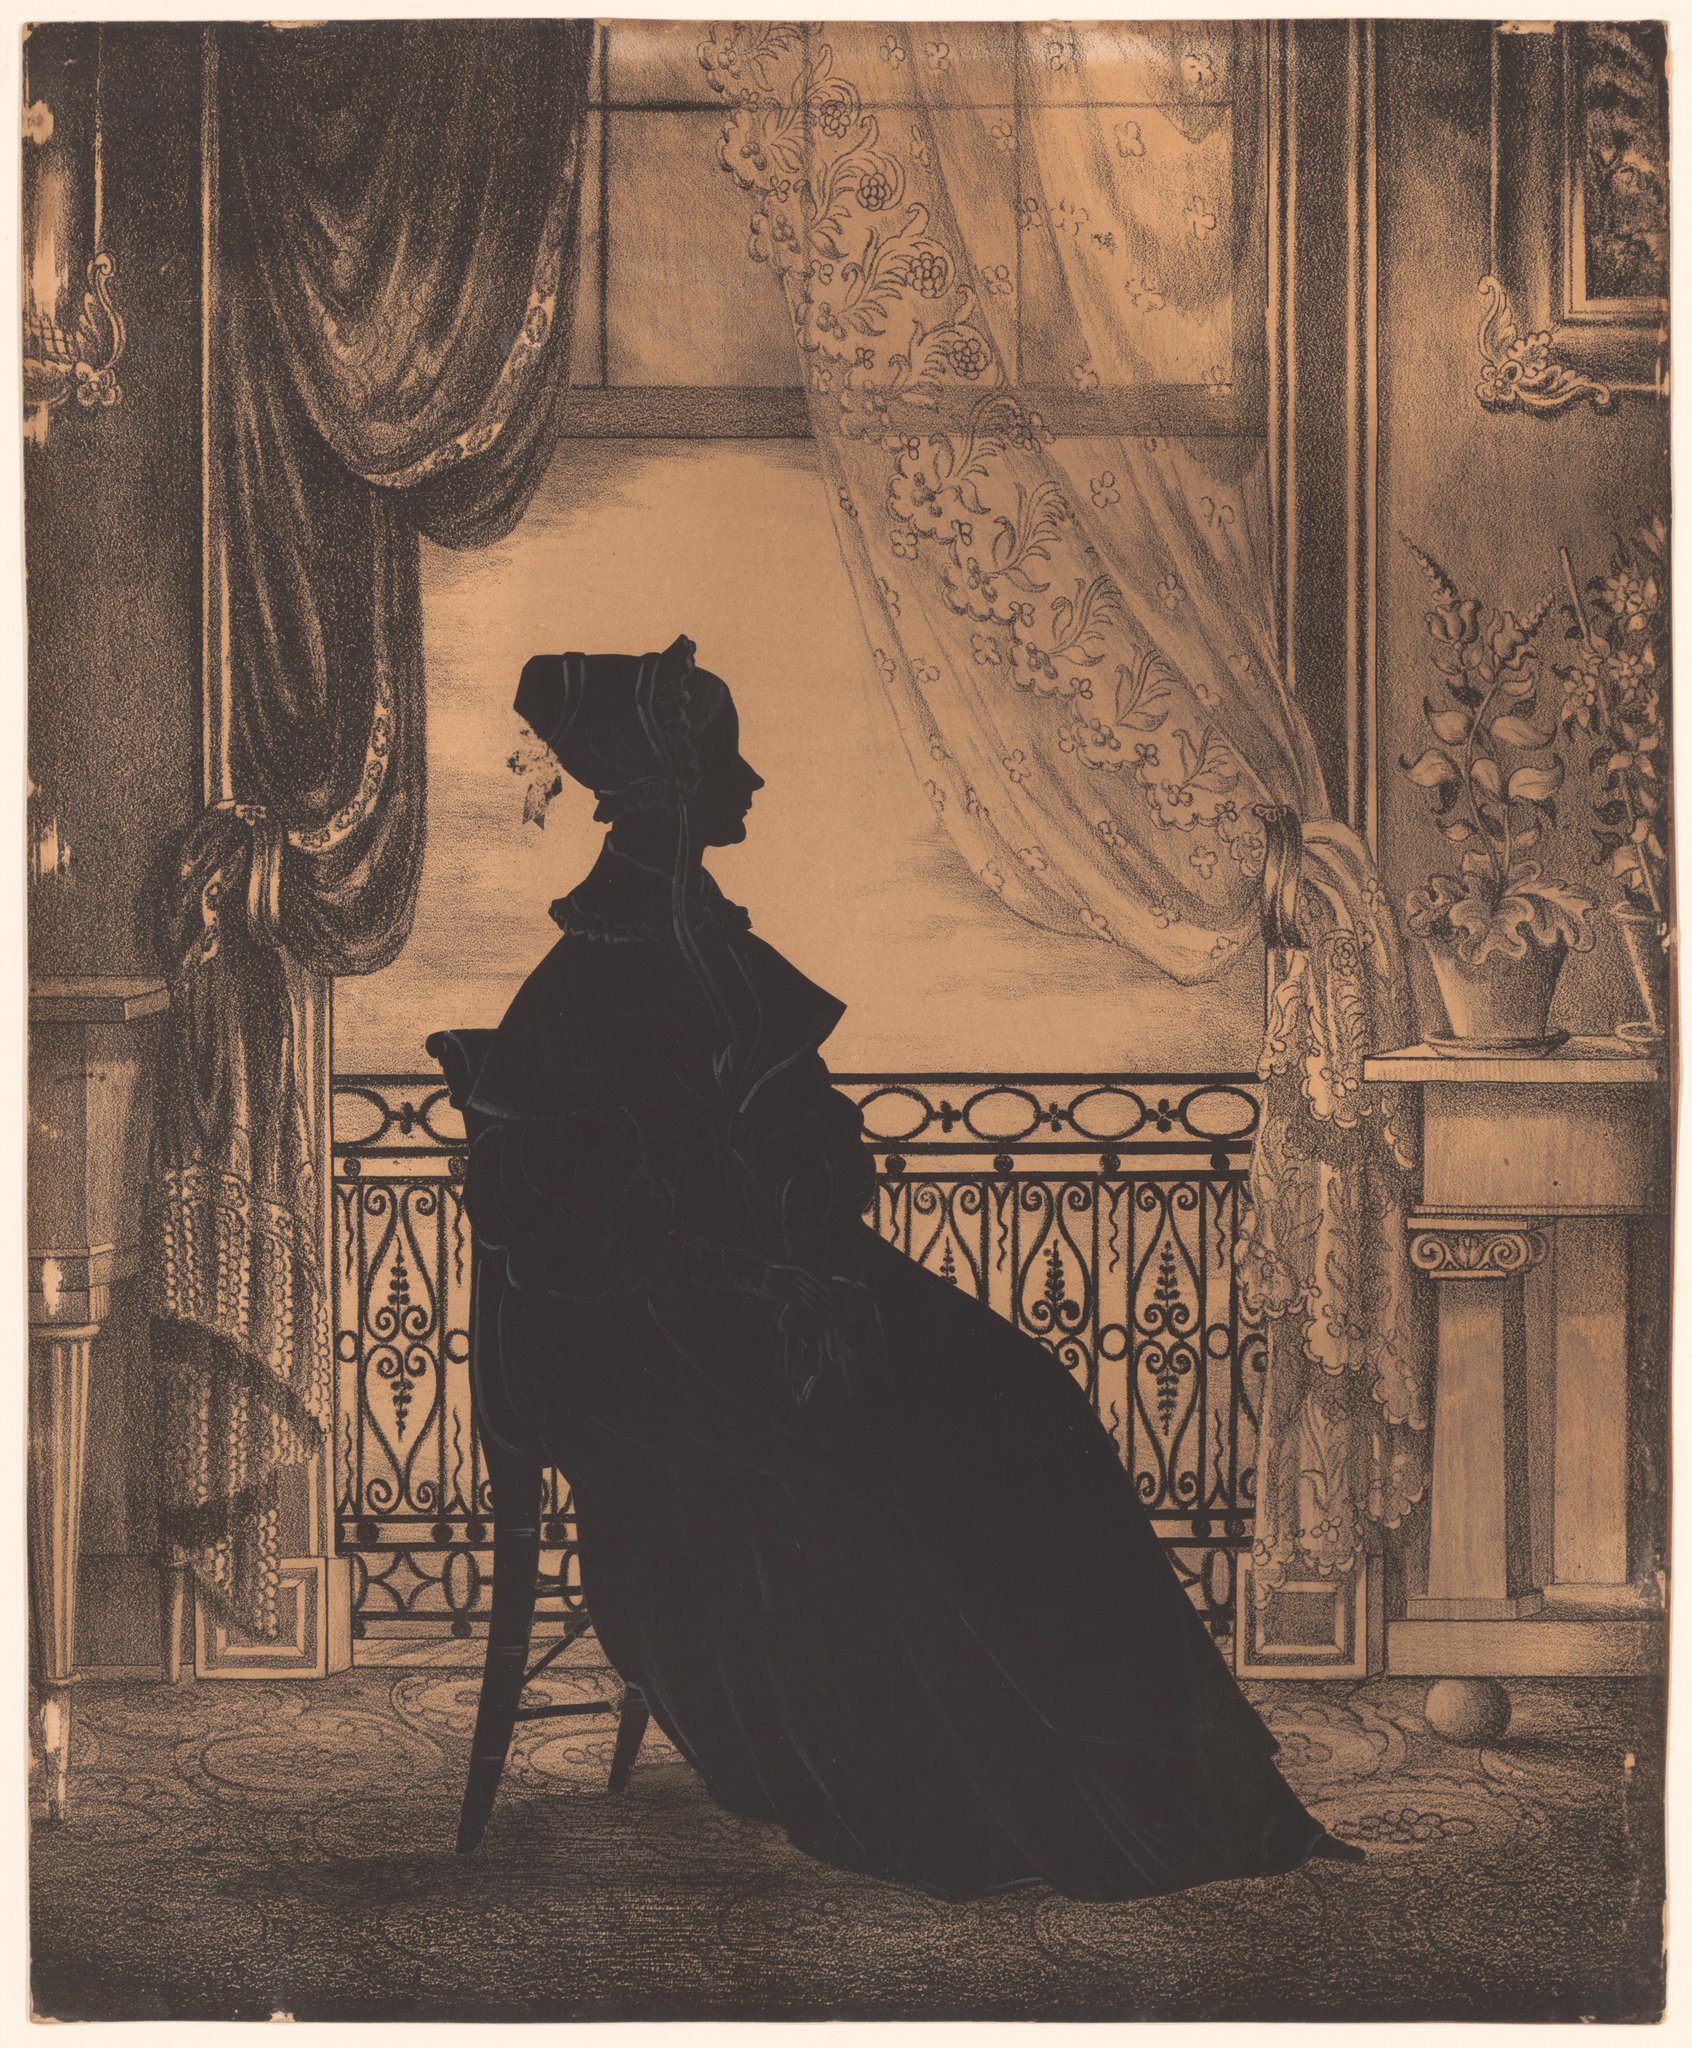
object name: cut paper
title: Portrait of a Woman before a Window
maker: william henry brown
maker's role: artist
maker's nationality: american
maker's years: 1808-1883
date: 1850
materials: paper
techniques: cutting, lithograph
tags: windows,portraits,women